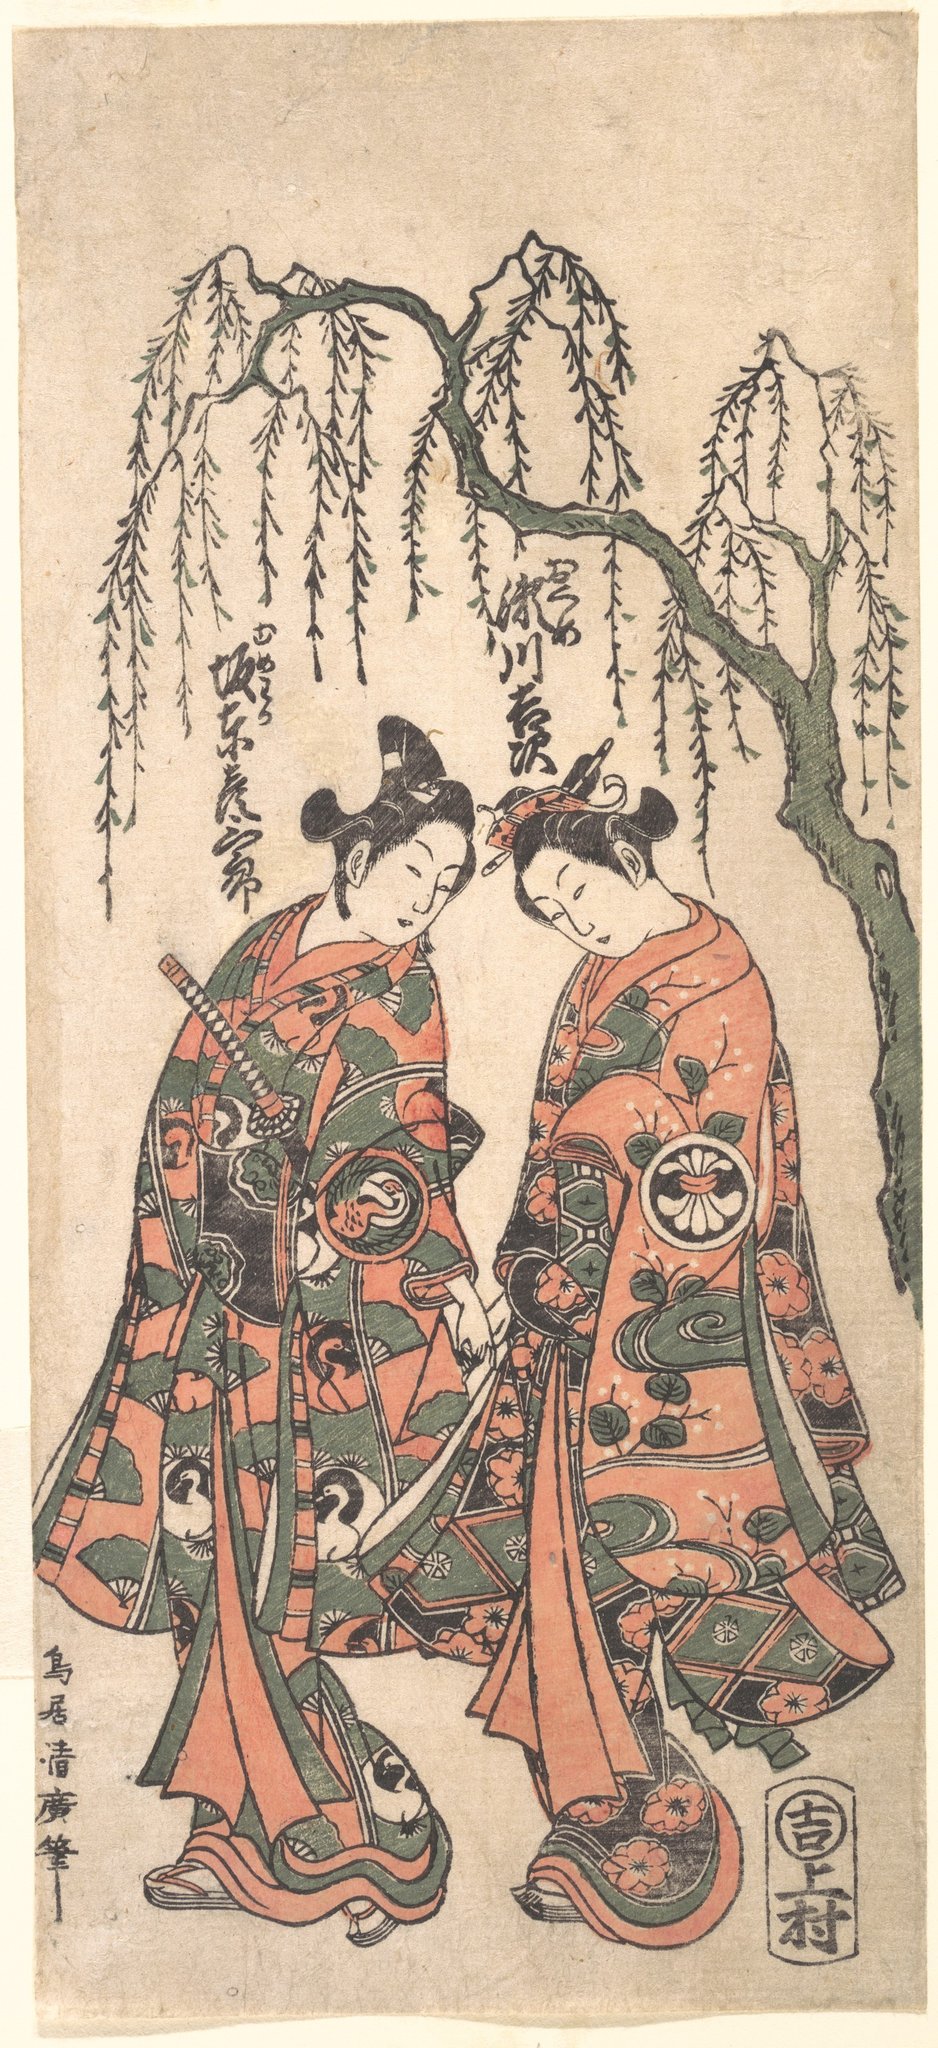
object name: woodblock print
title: Young Lovers under a Drooping Willow, Their Hands Clasped, Their Heads Bent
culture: japanese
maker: torii kiyohiro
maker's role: artist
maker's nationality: japanese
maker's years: 1737-1776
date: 1754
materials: ink, paper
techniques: woodblock print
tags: lovers,trees